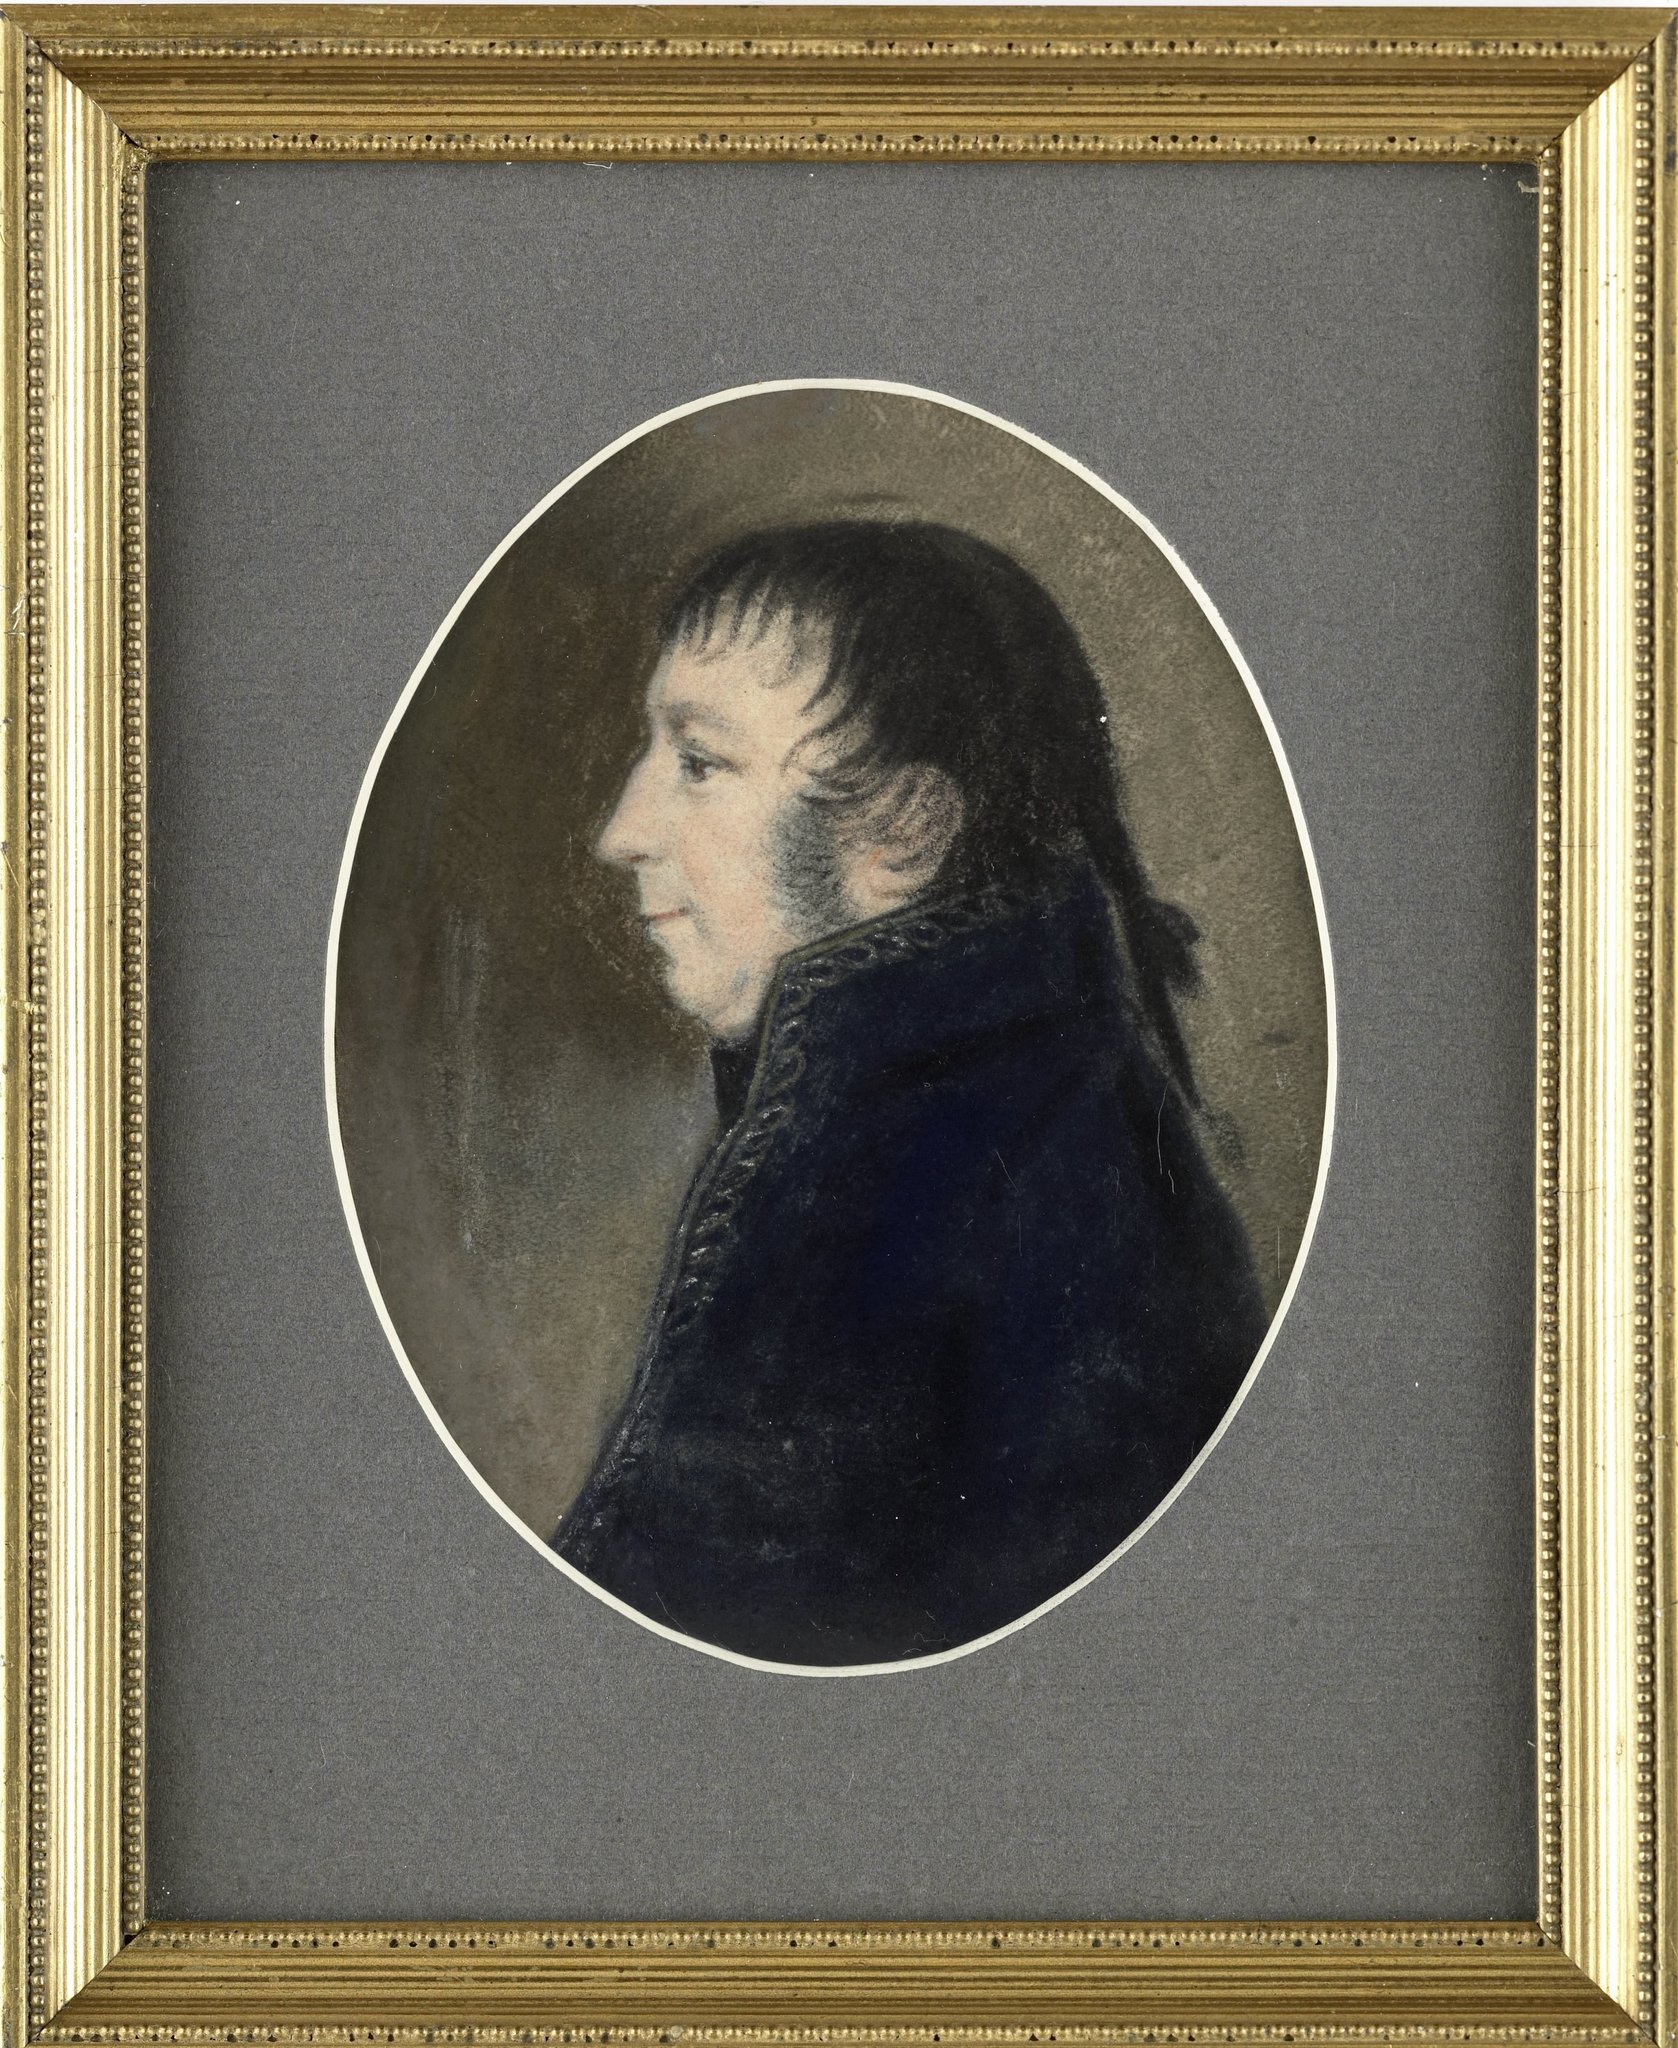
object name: pastel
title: Albert Kikkert (1762-1819). Vice-admiraal en gouverneur-generaal van Curaçao, Aruba en Bonaire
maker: johan anspach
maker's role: draughtsman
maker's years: 1752-1823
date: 1782-1819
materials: parchment, pastel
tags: colonial governor, historical persons, commander-in-chief, admiral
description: Portret van Albert Kikkert (1762-1819). Vice-admiraal en gouverneur-generaal van Curaçao, Aruba en Bonaire. Buste, in profiel naar links. Onderdeel van de collectie pastels.